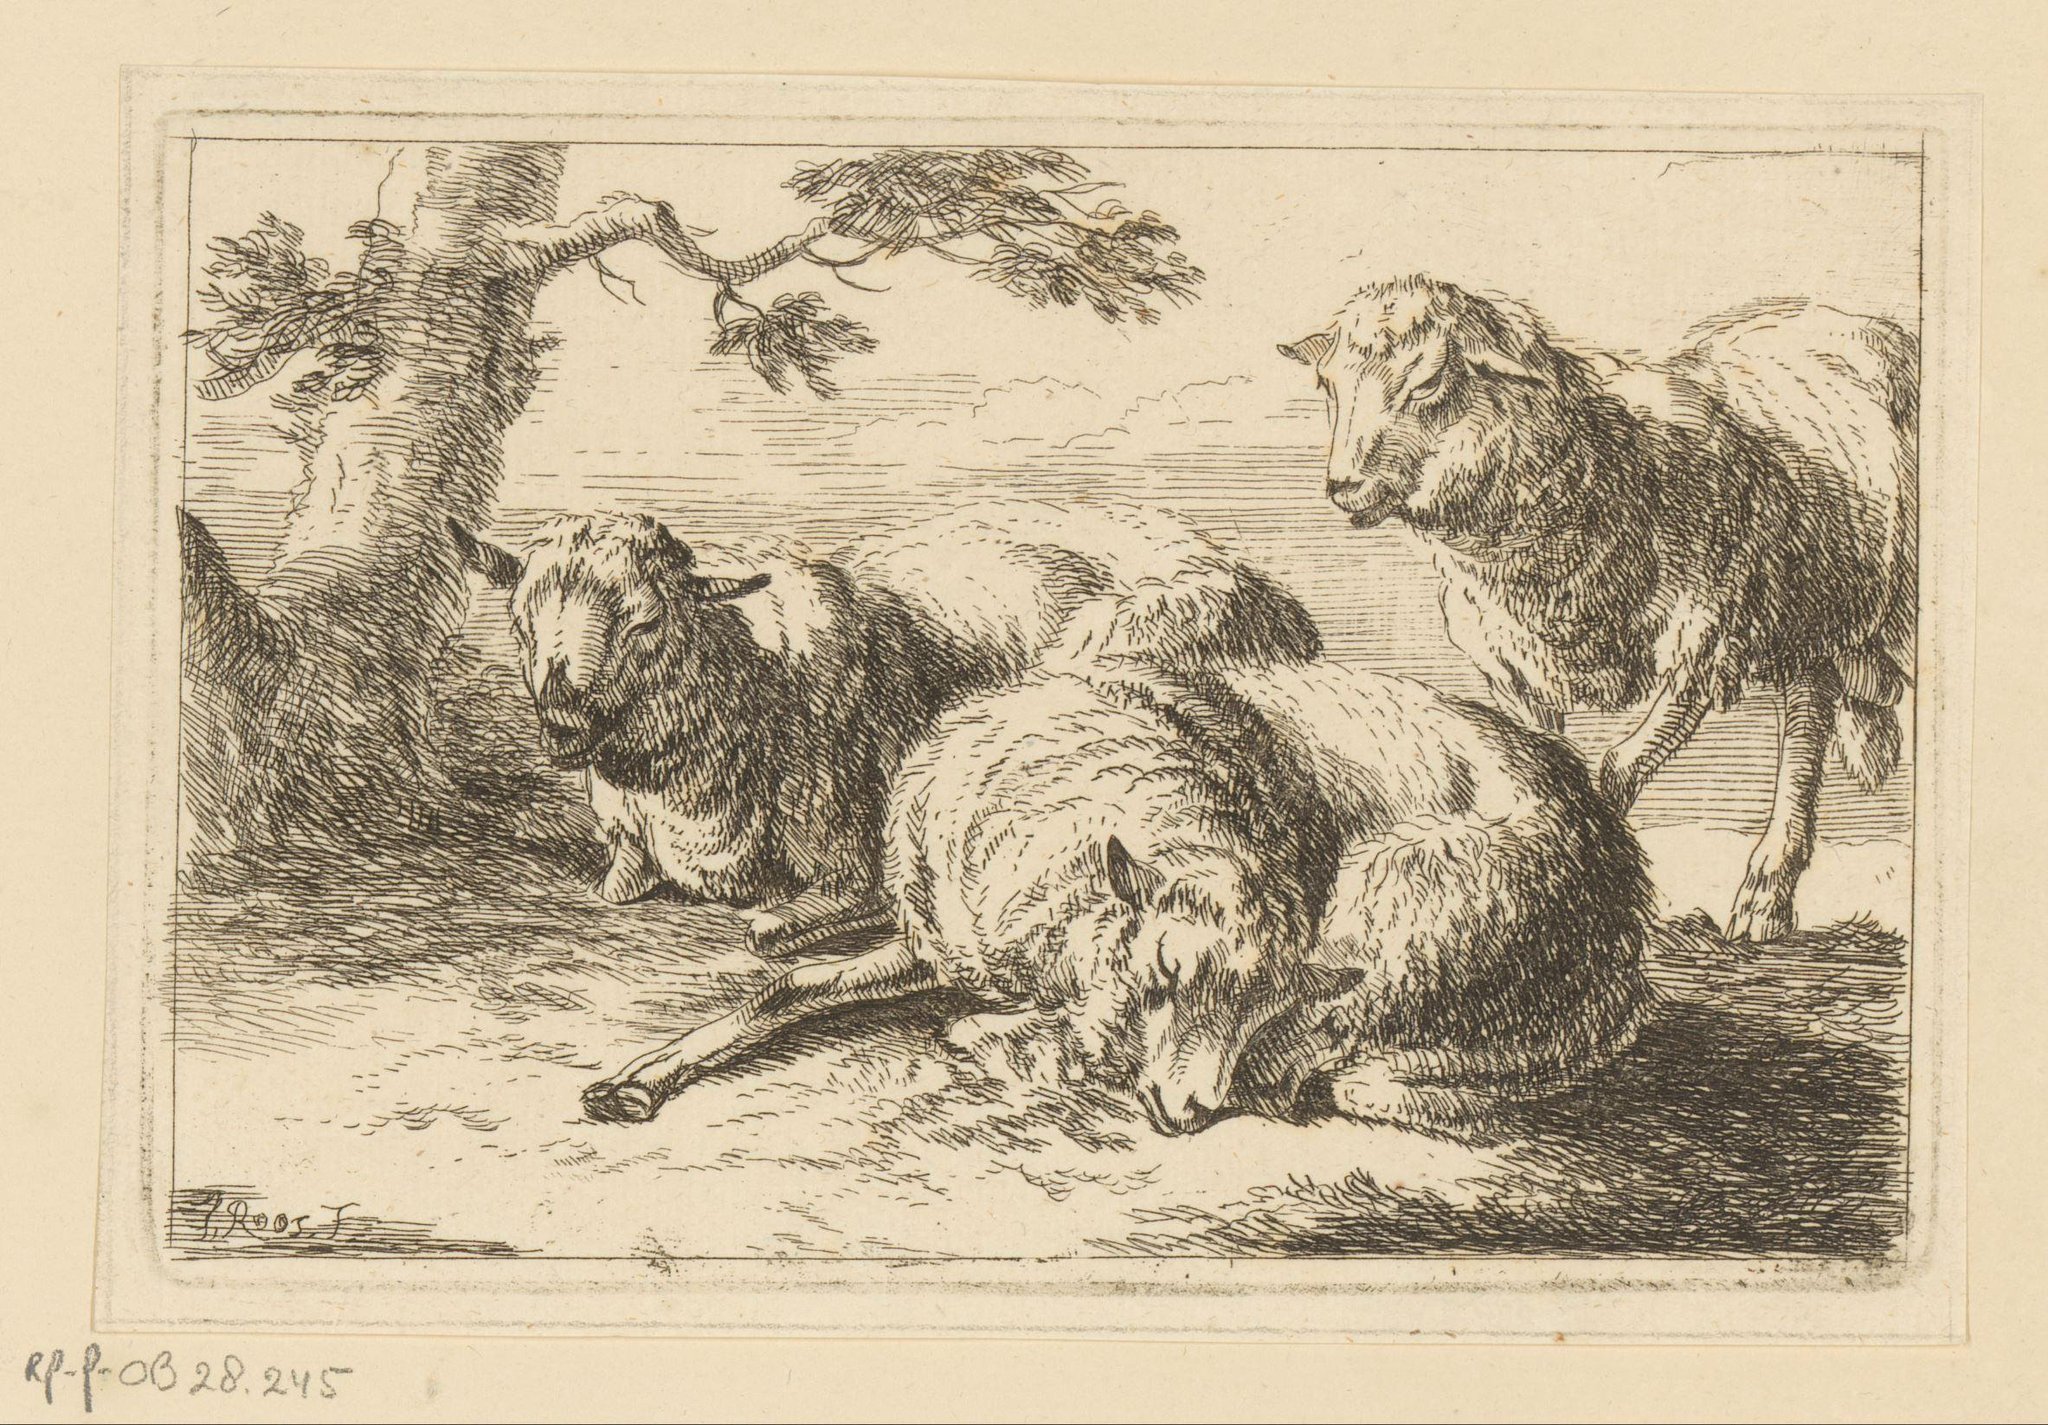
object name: print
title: Drie schapen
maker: joseph roos (i)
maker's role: print maker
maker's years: 1726-1805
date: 1754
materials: paper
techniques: etching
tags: landscapes, sheep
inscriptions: collector's mark: Lugt 240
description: Serie van twaalf prenten, waarvan één titelprent.